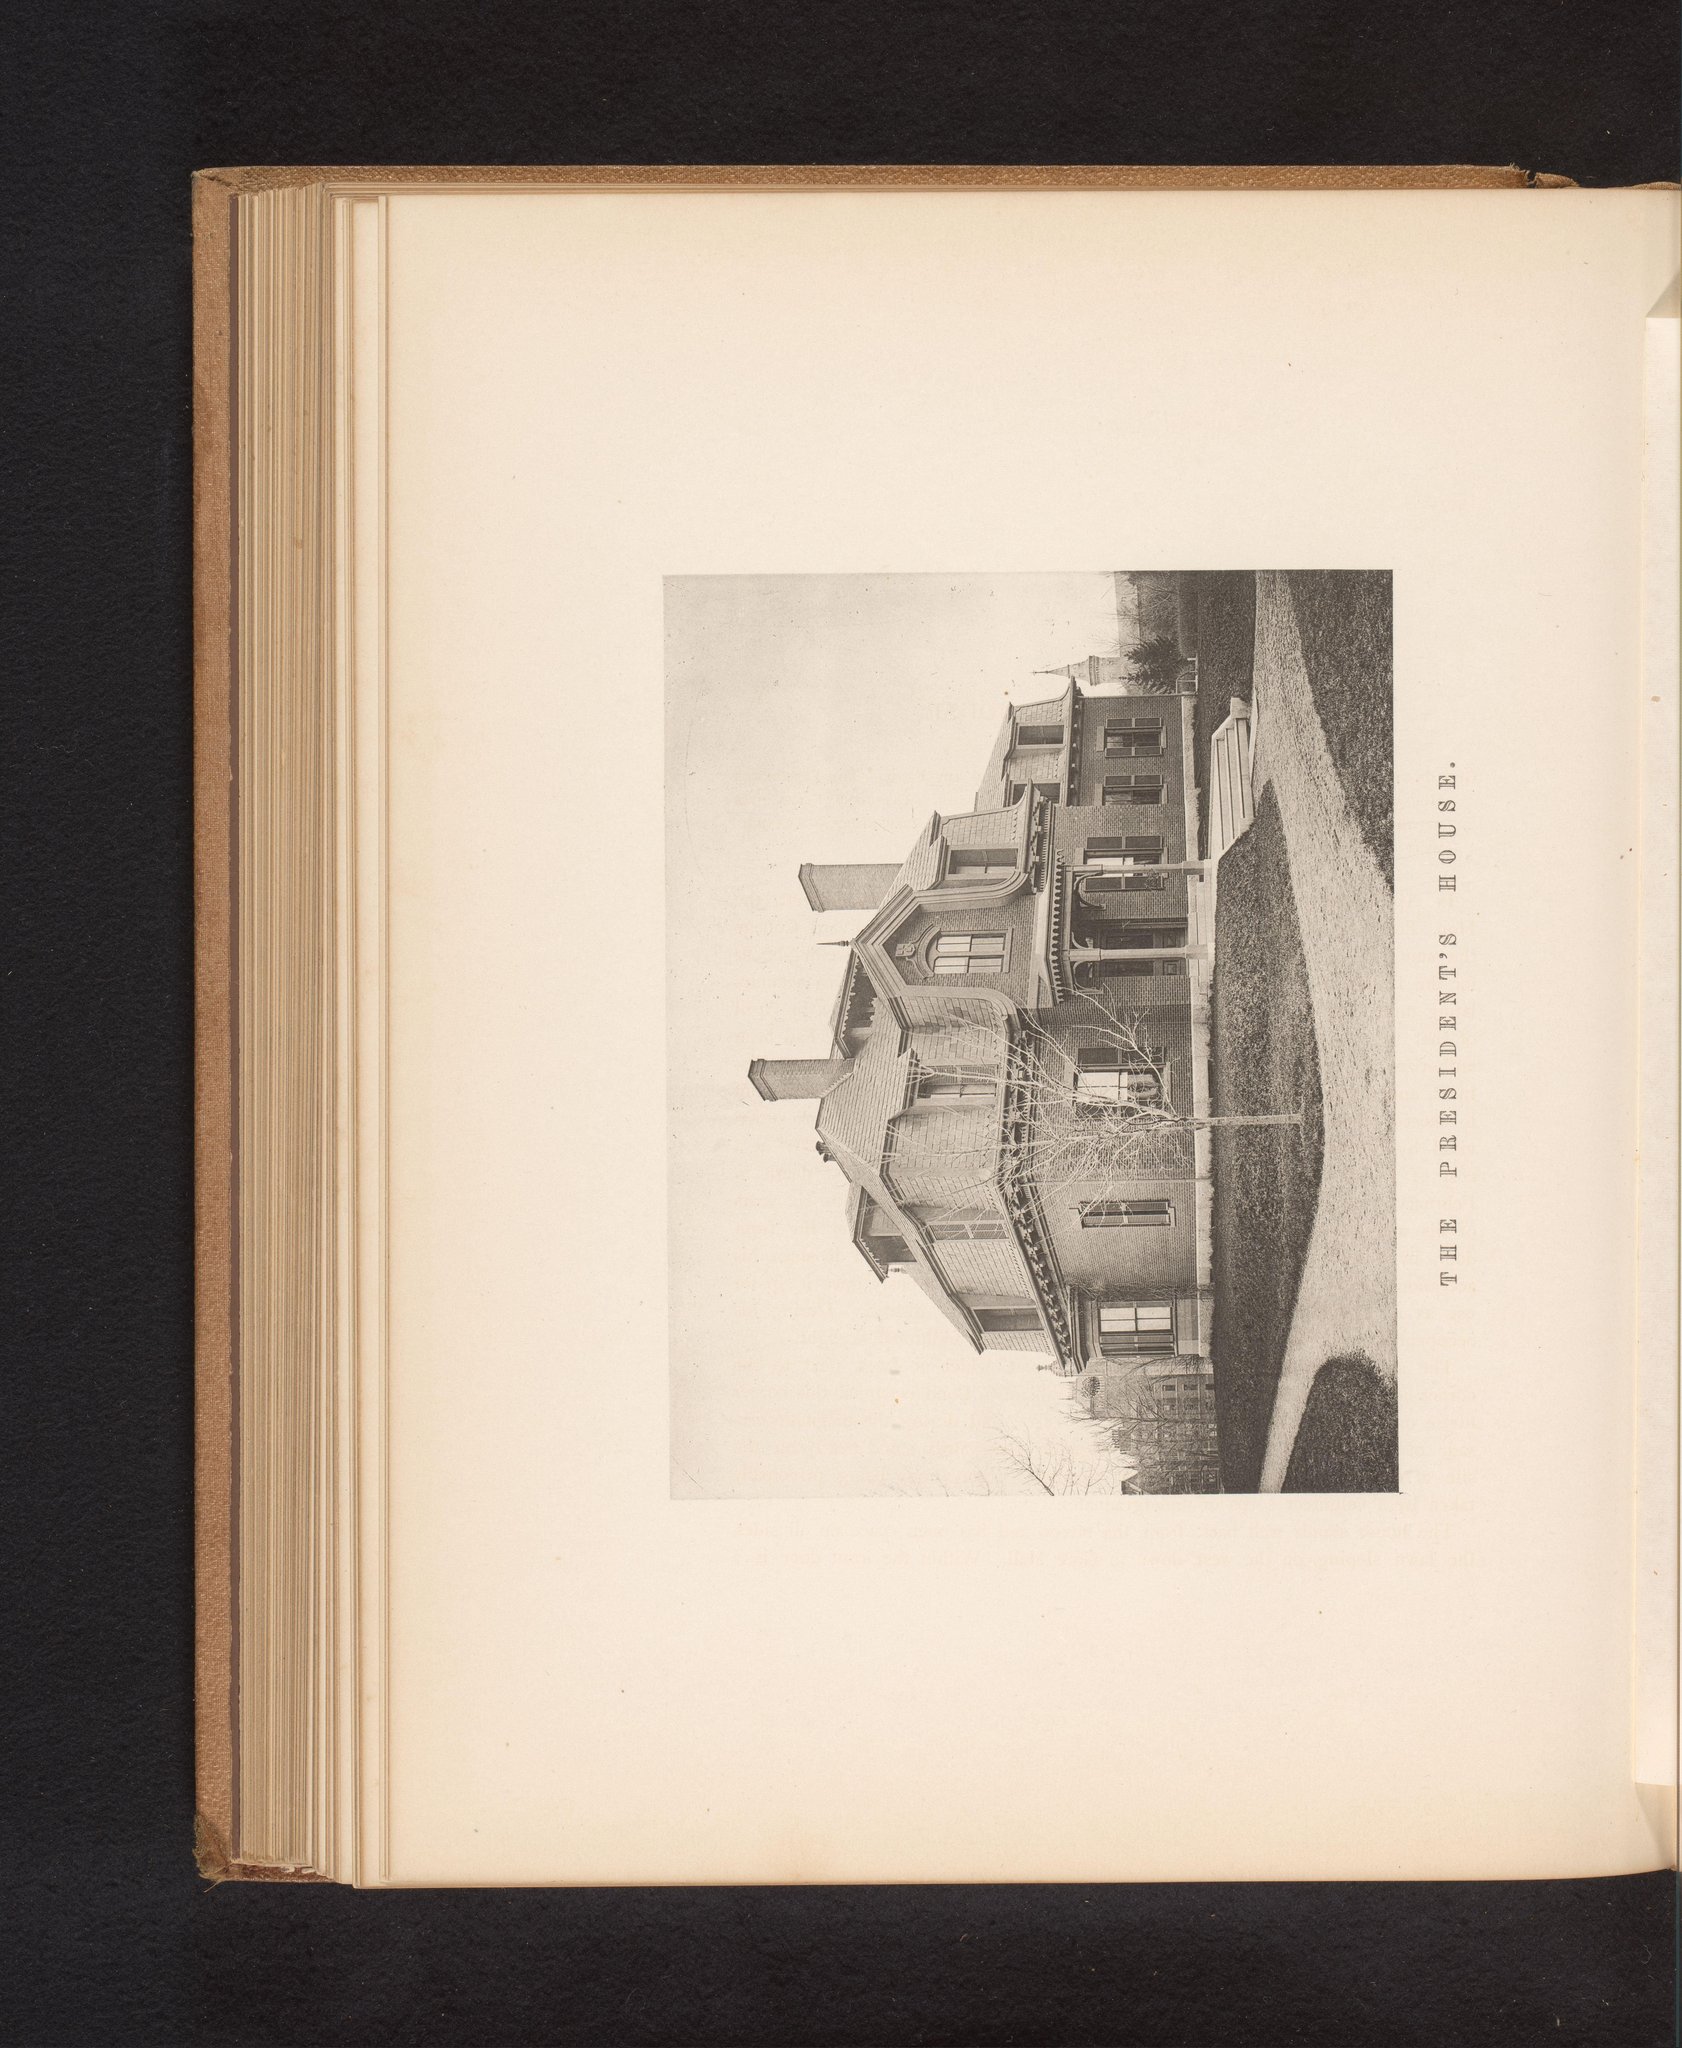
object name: page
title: The president's house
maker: Anonymous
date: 1870-1875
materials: paper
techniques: photograph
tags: detached house in city, university building, college